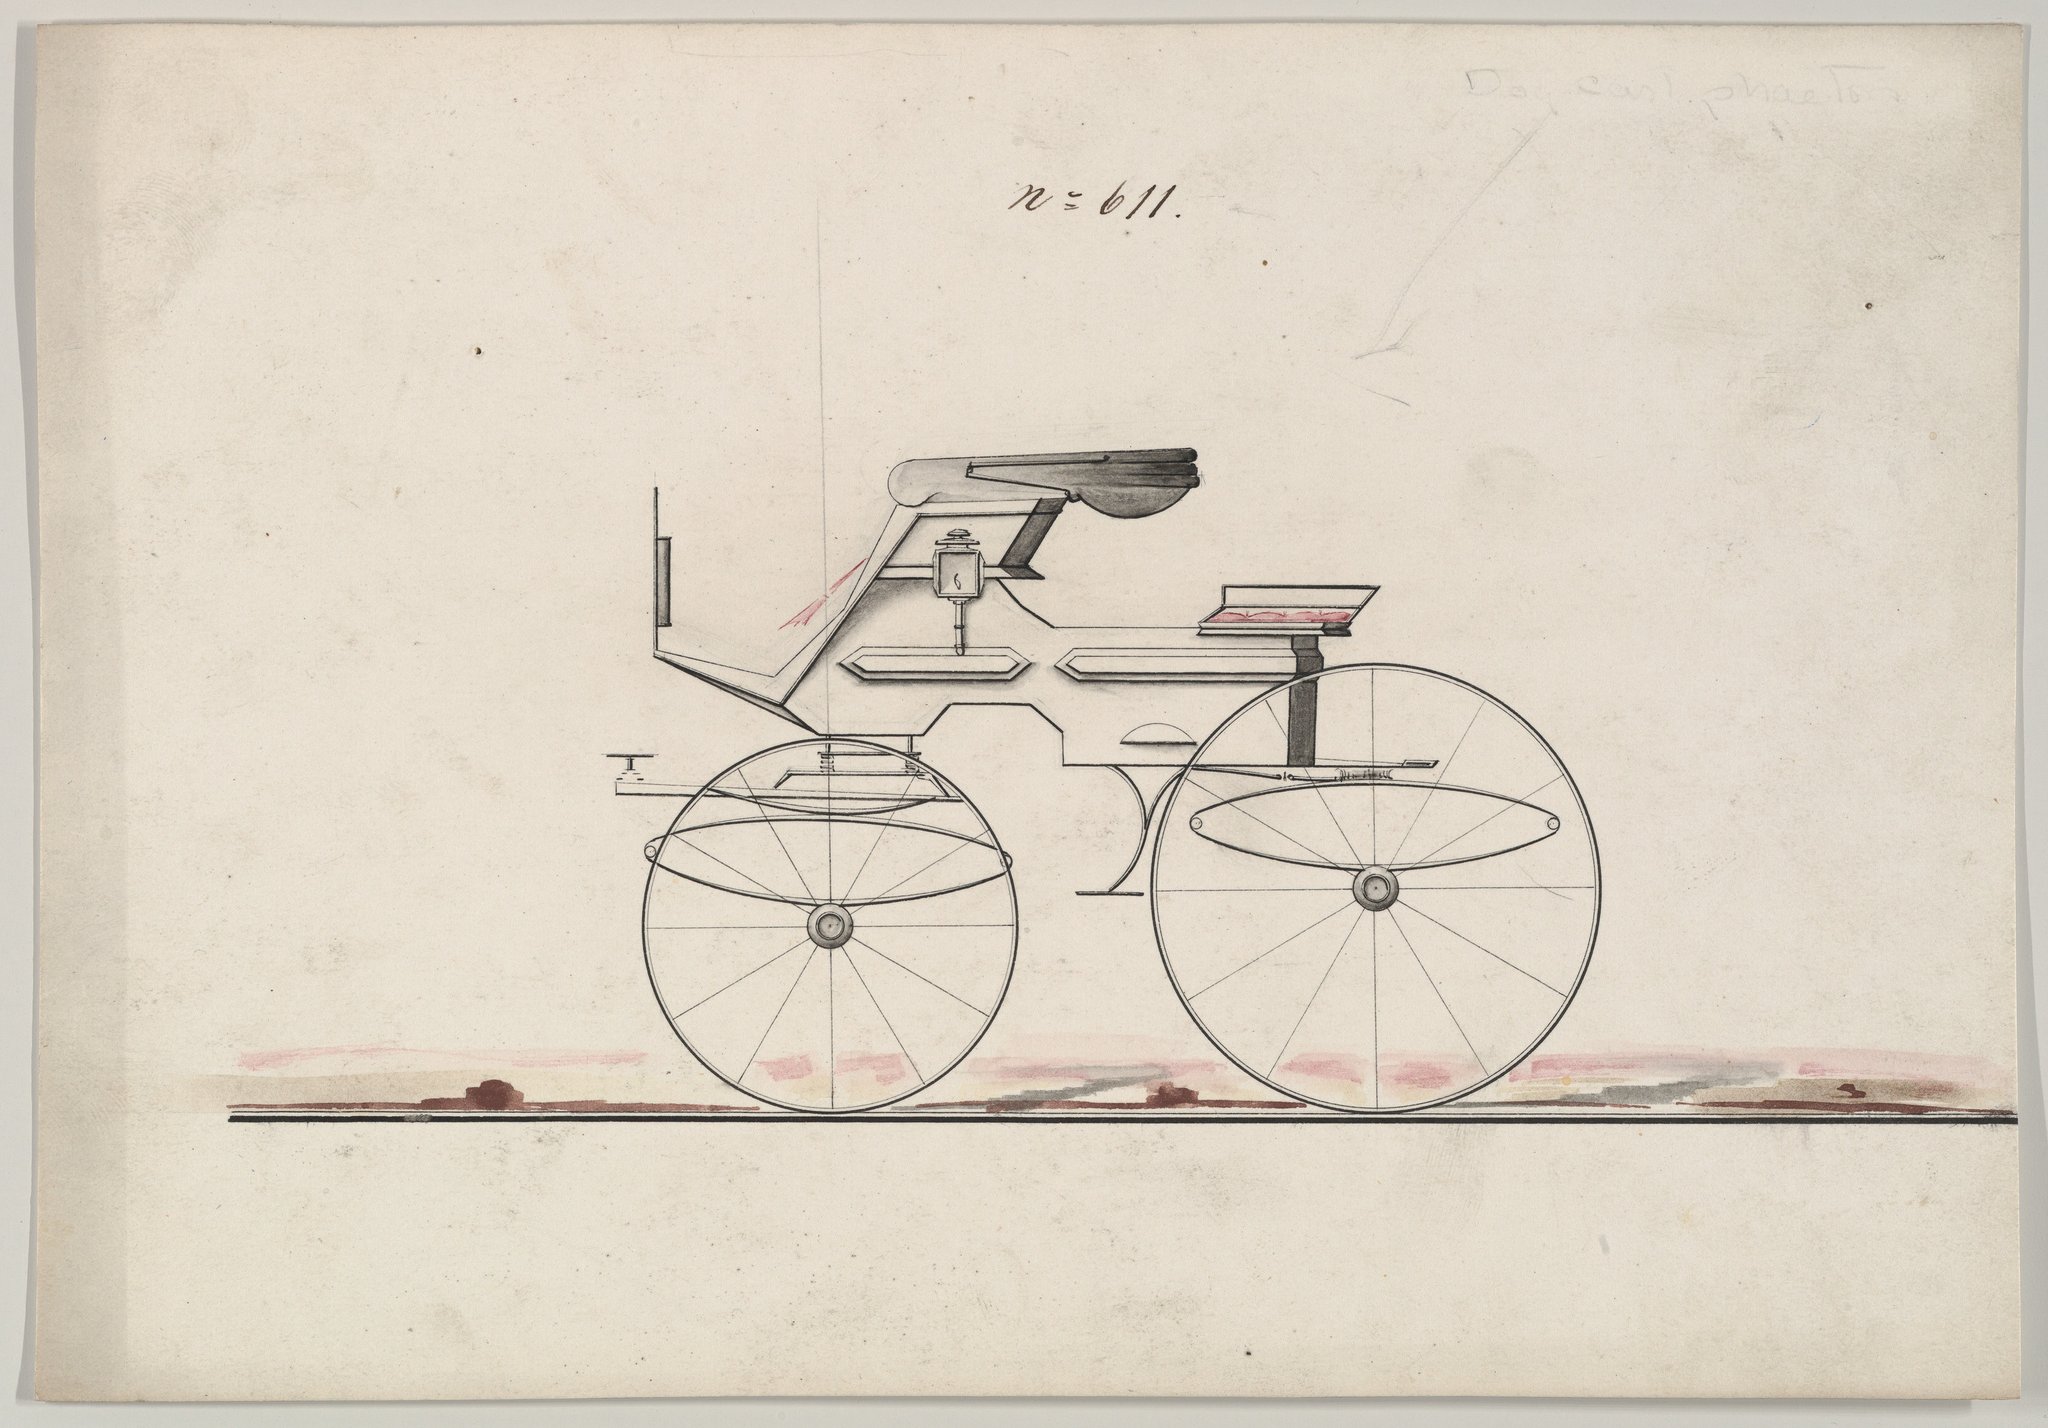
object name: drawing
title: Design for "Dog Cart" Phaeton, no. 611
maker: brewster & co.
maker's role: manufacturer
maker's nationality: american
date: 1850-1874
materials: gouache, ink, watercolor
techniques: pen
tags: carriages